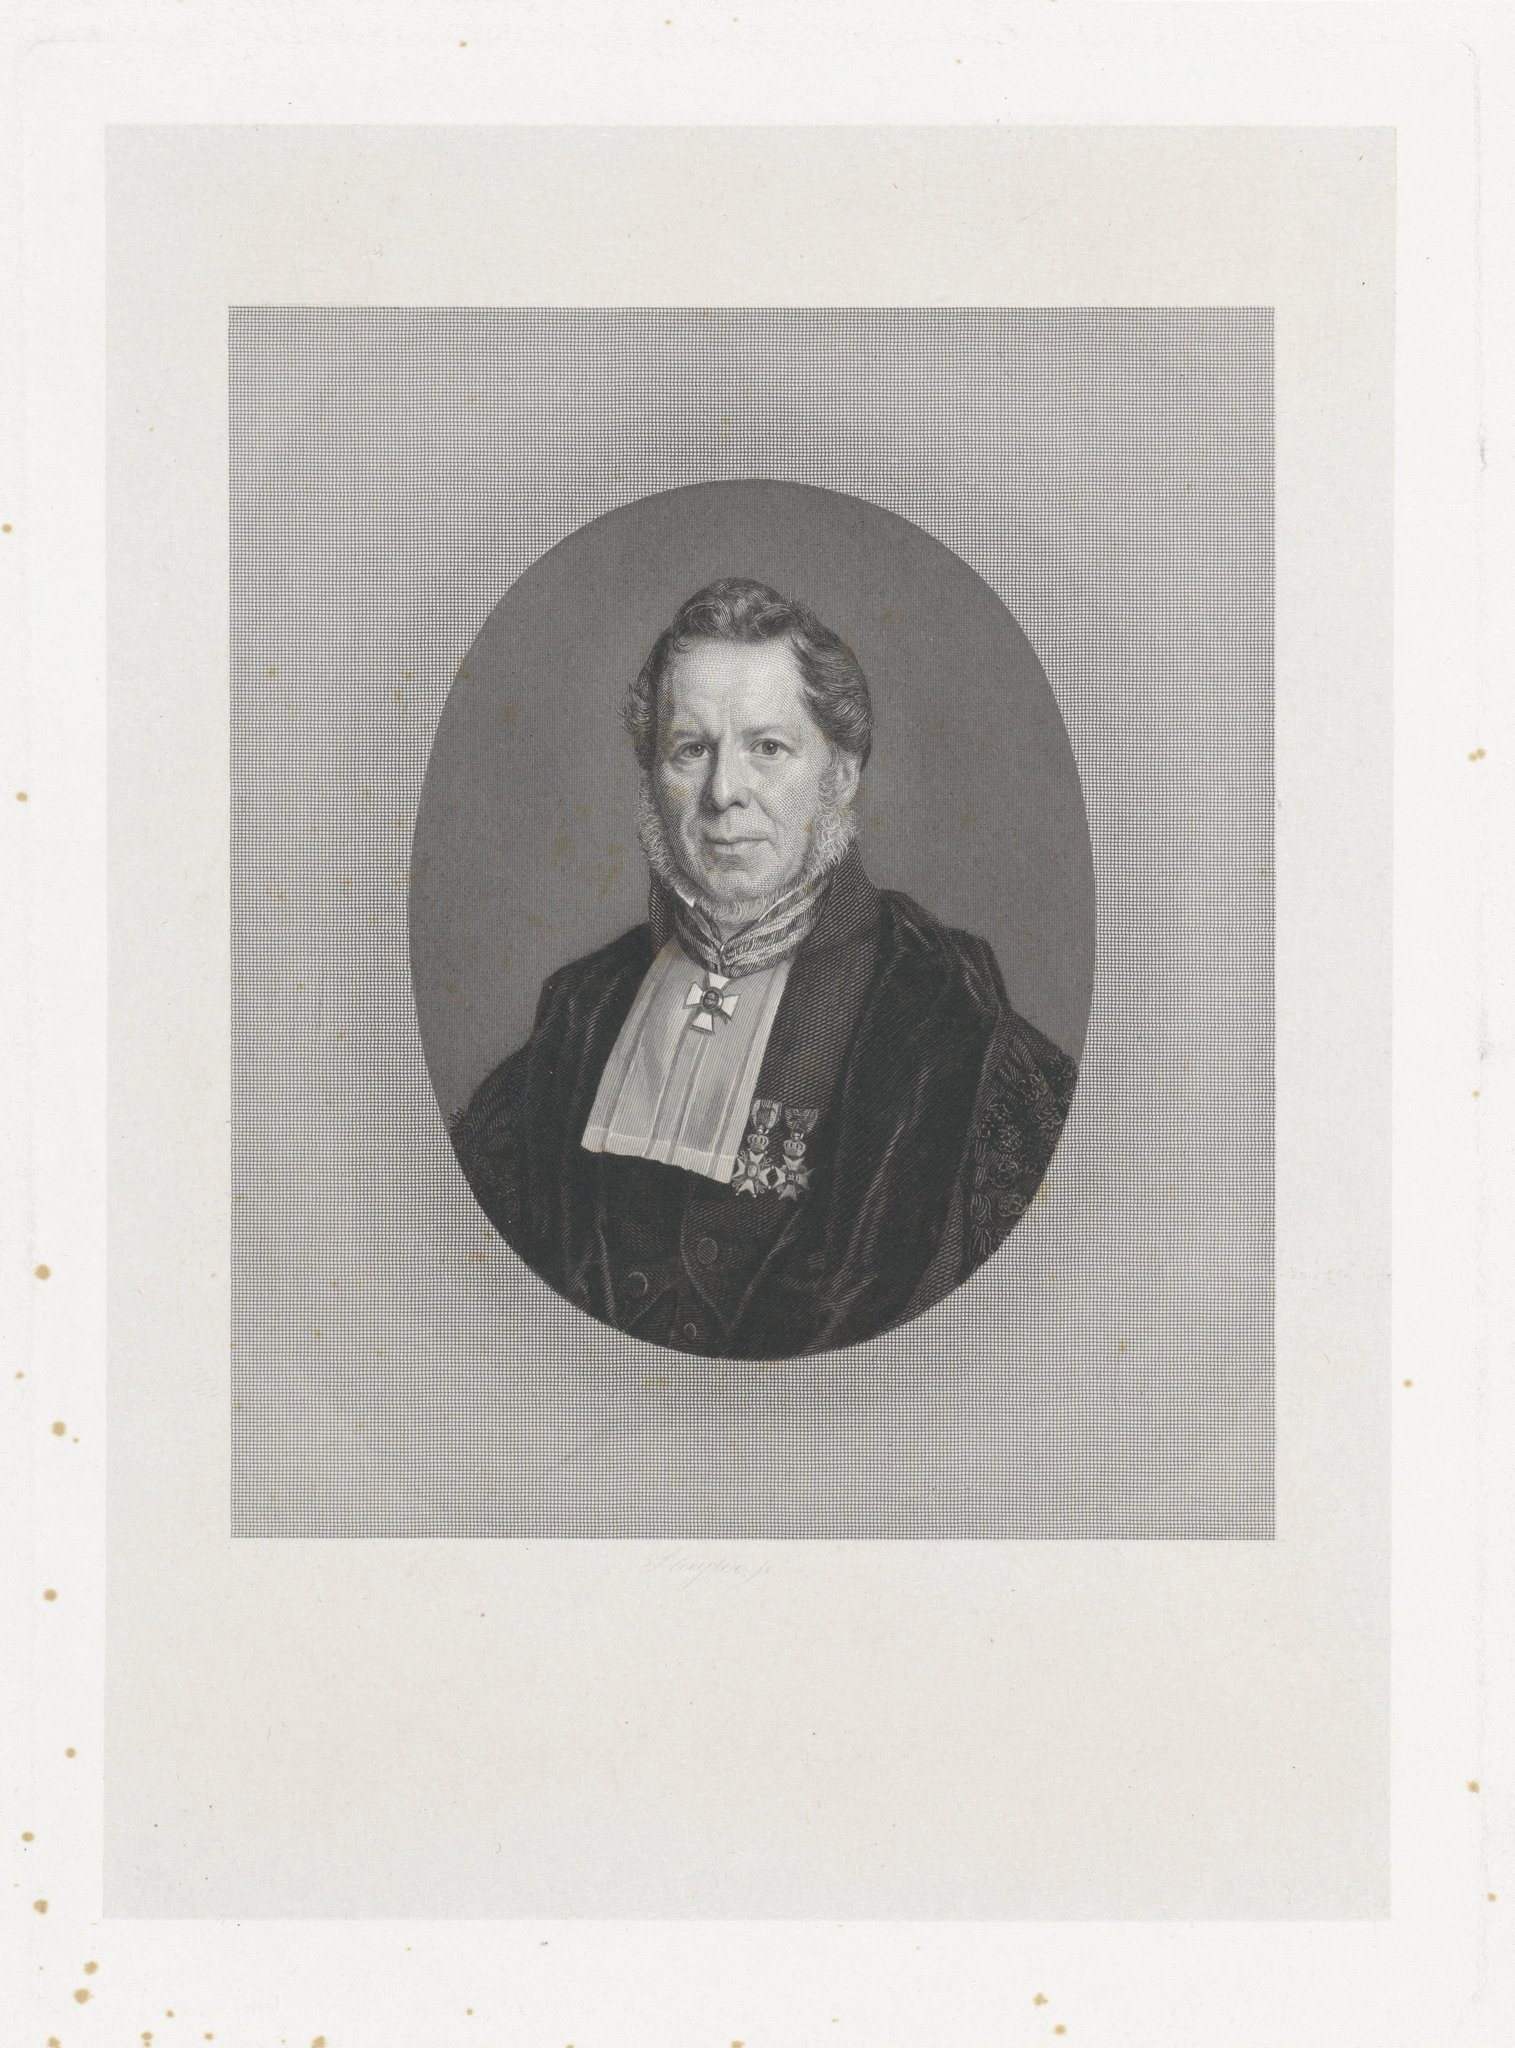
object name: print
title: Portret van de hoogleraar Jacobus Ludovicus Conradus Schroeder van der Kolk.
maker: dirk jurriaan sluyter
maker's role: draughtsman, print maker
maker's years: 1811-1886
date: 1860-1879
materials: paper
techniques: etching, engraving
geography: amsterdam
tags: utrecht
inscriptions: collector's mark: Lugt 12